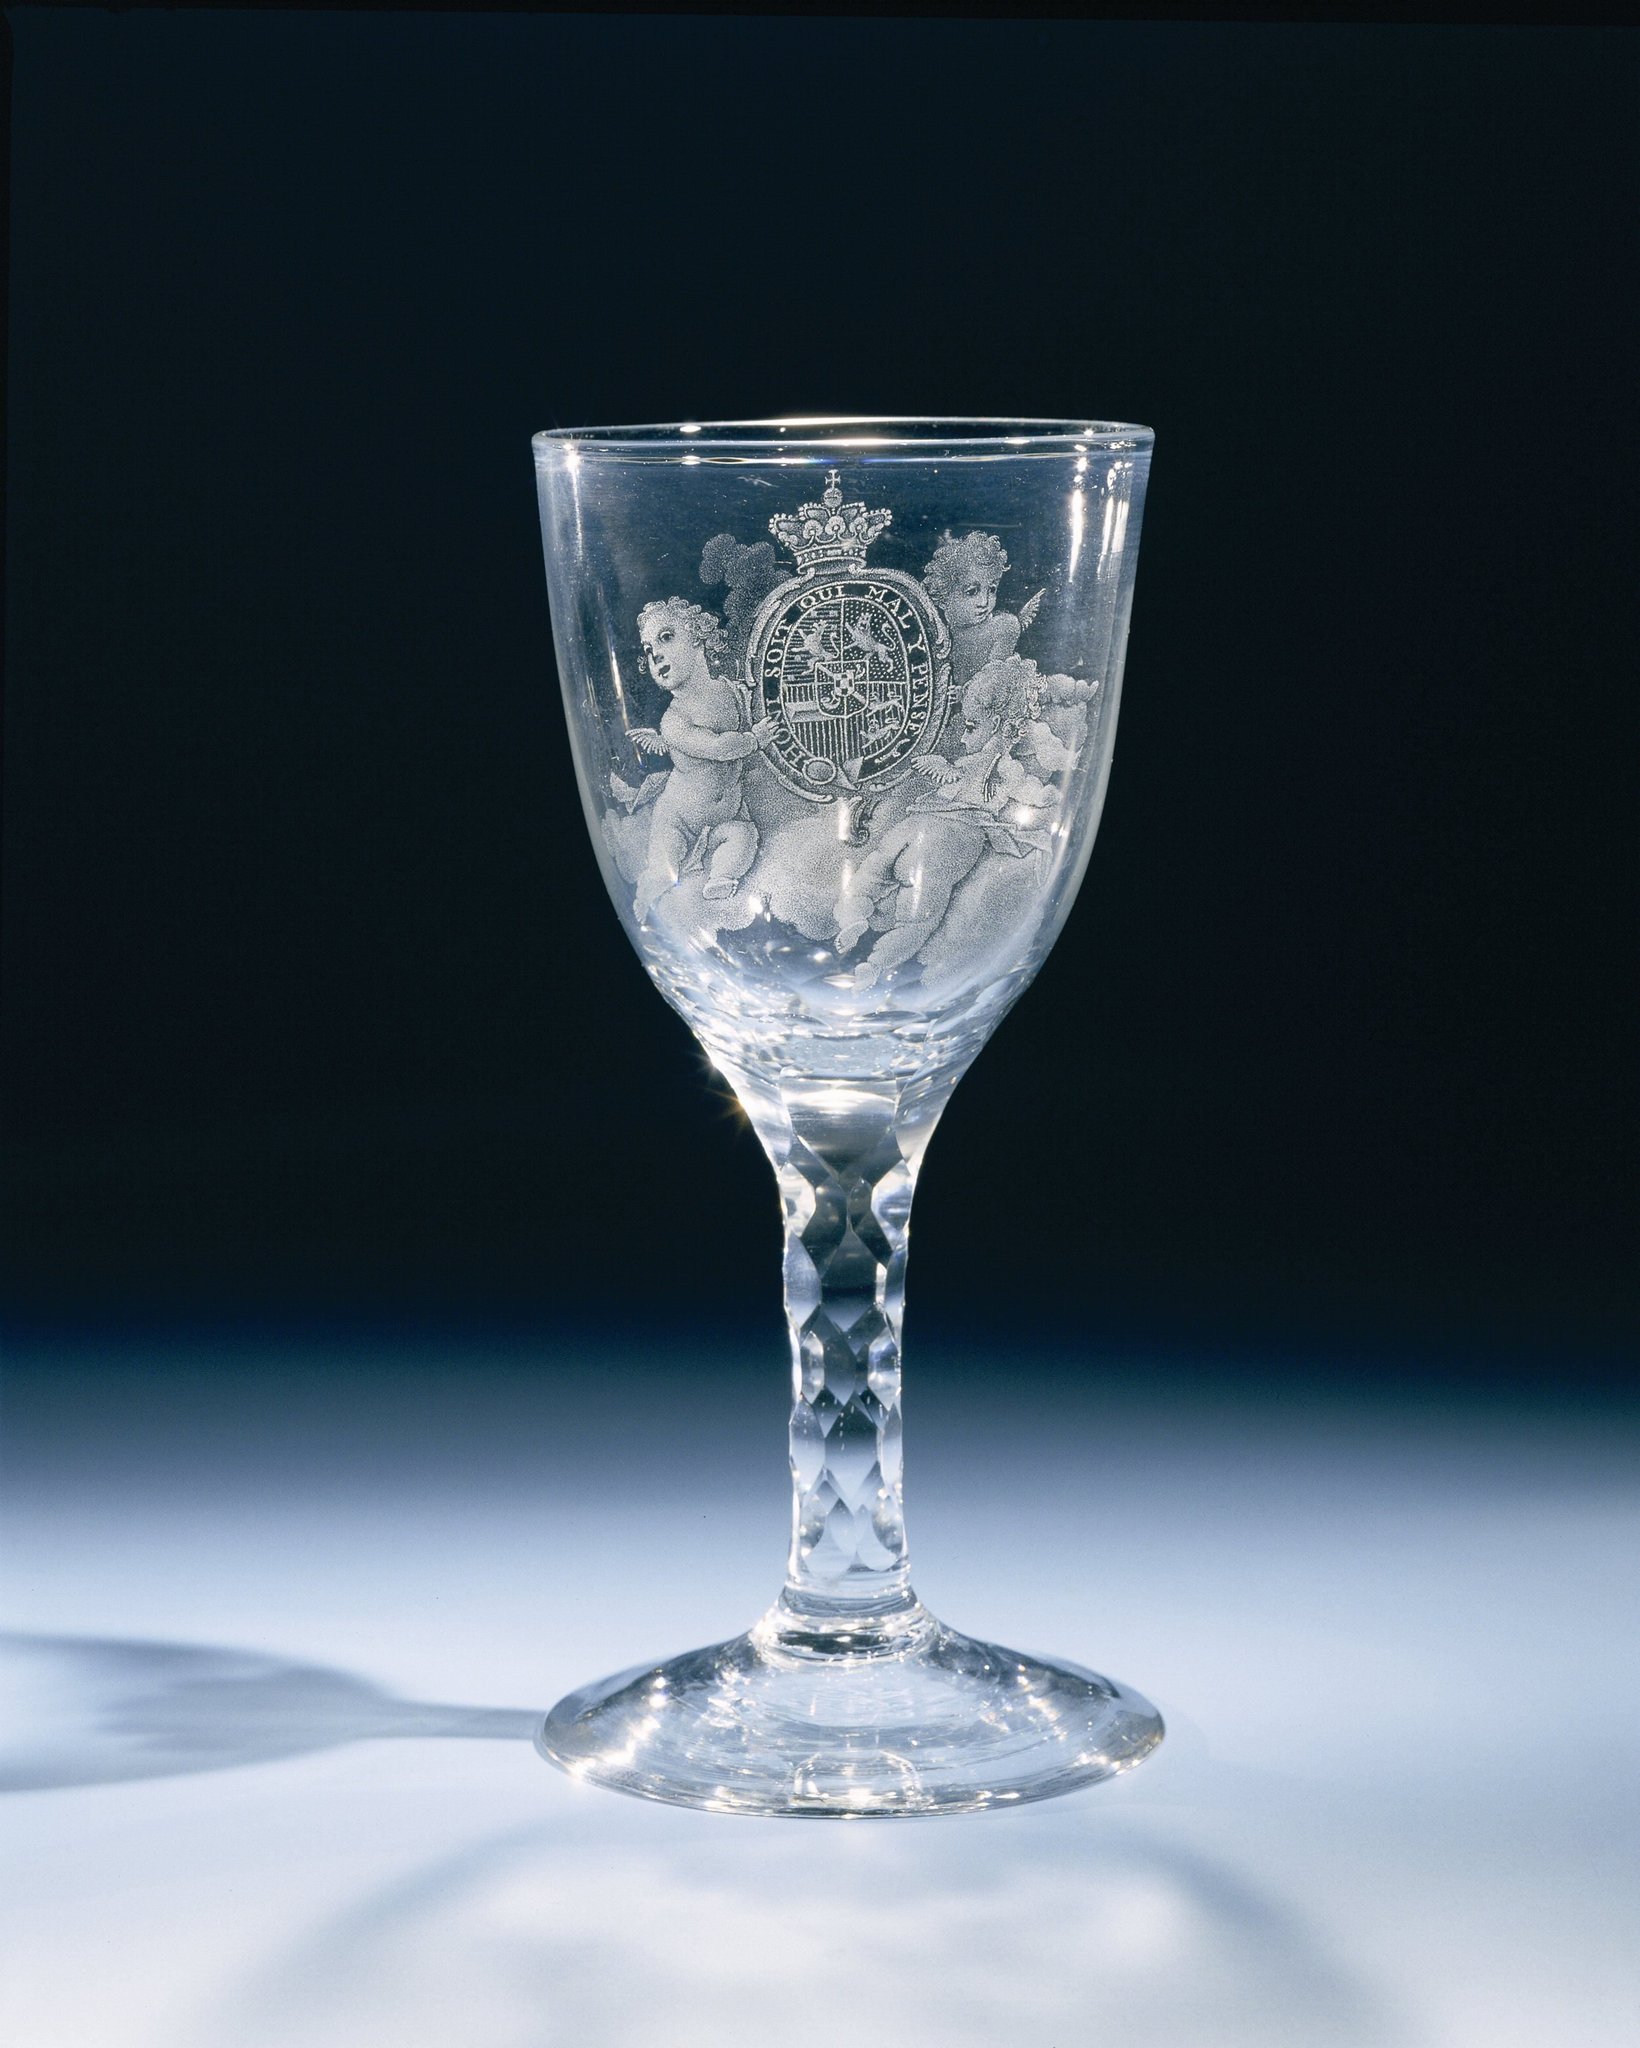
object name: goblet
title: Kelkglas met het wapen van Willem V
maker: david wolff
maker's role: glasgraveur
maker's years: 1732-1798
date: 1775-1798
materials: glass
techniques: glassblowing, grinding, engraving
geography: northern netherlands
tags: the hague, william v (prince of orange)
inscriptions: inscription: ‘HONI SOIT QUI MAL Y PENSE’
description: Coat of arms of Stadholder William V, c. 1775 - 1798.